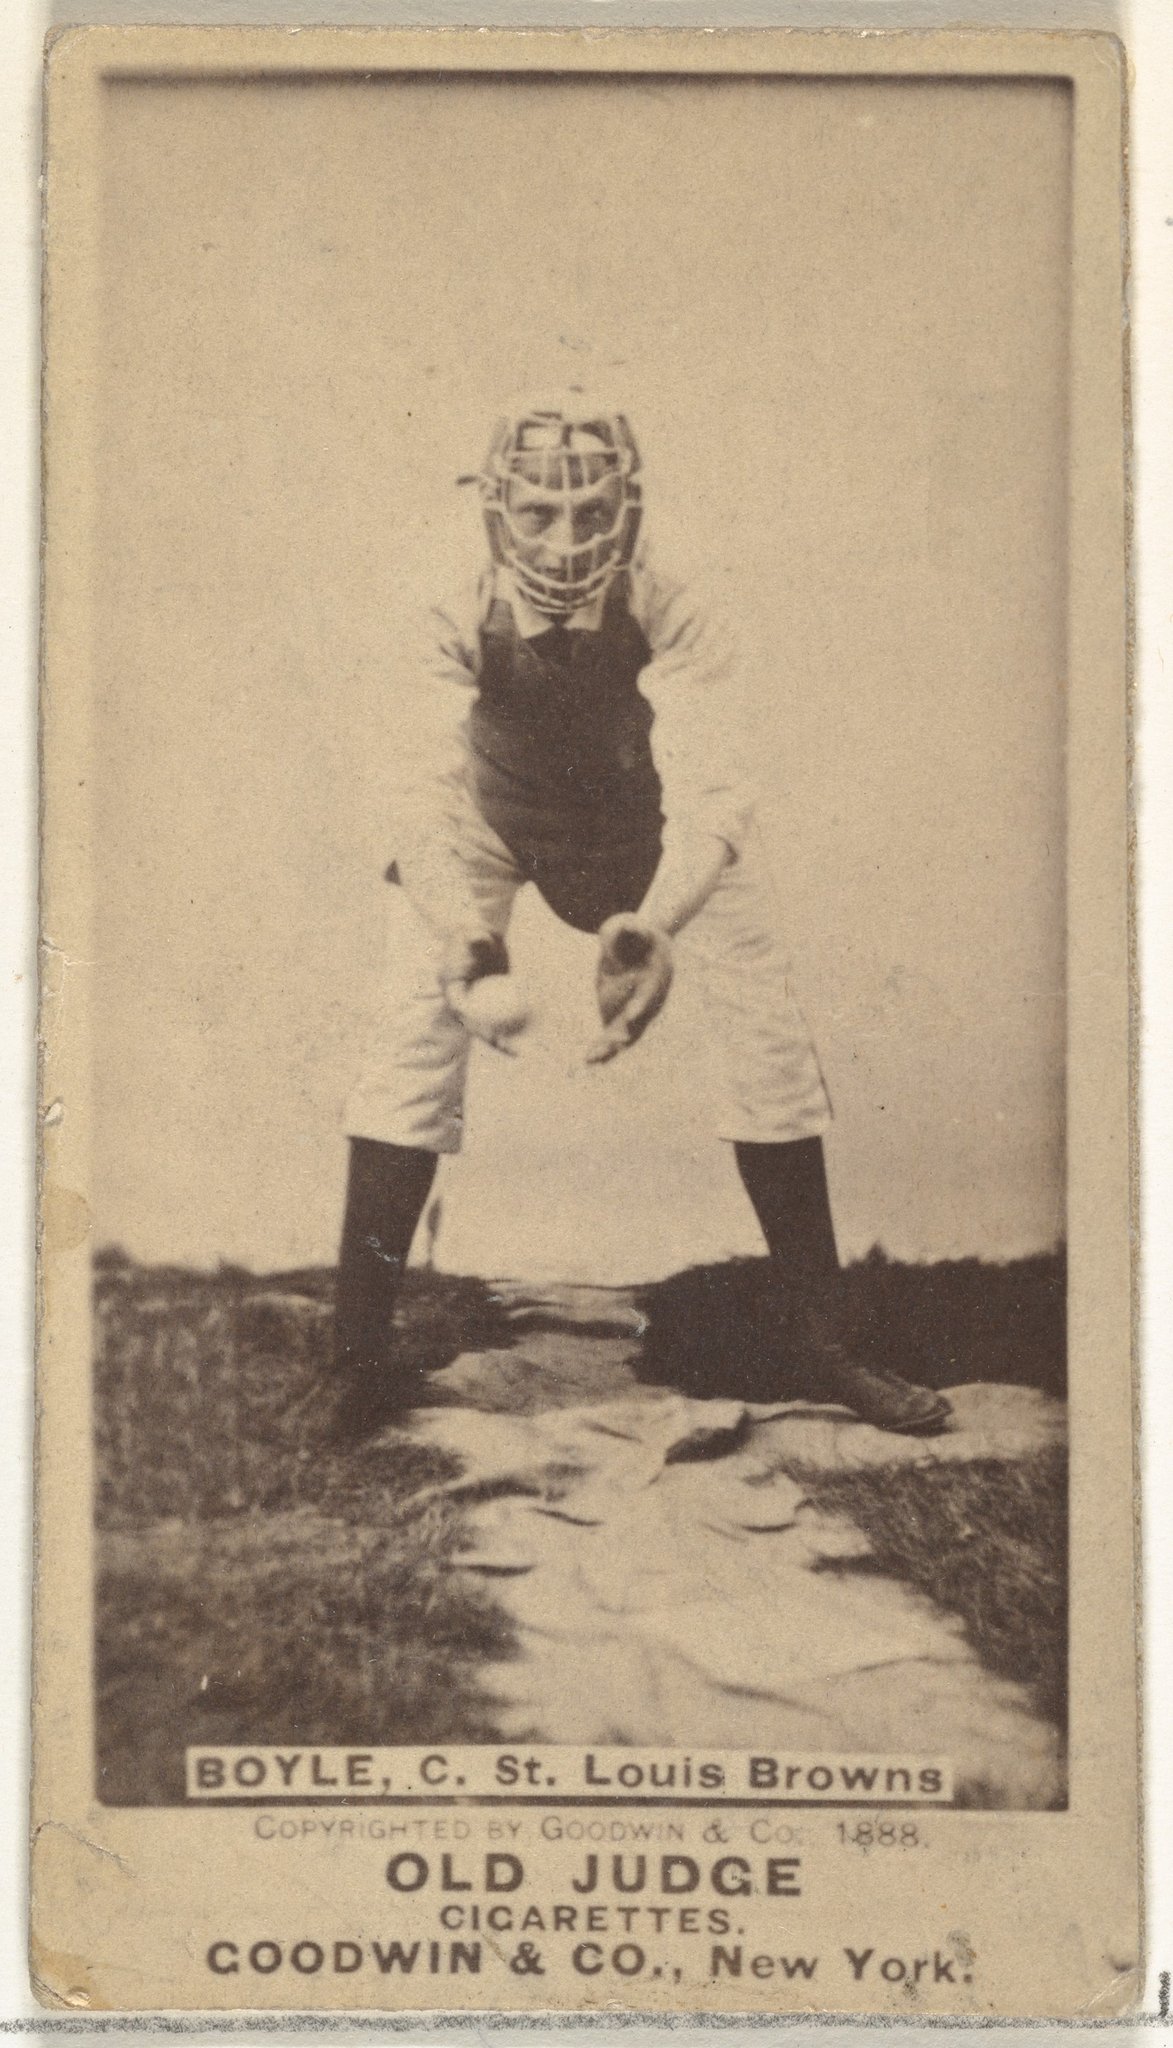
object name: baseball card, photograph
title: John Anthony "Honest John" Boyle, Catcher, St. Louis Browns, from the Old Judge series (N172) for Old Judge Cigarettes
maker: goodwin & company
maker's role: publisher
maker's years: 1850-1950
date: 1888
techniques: albumen silver print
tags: men,portraits,baseball,athletes